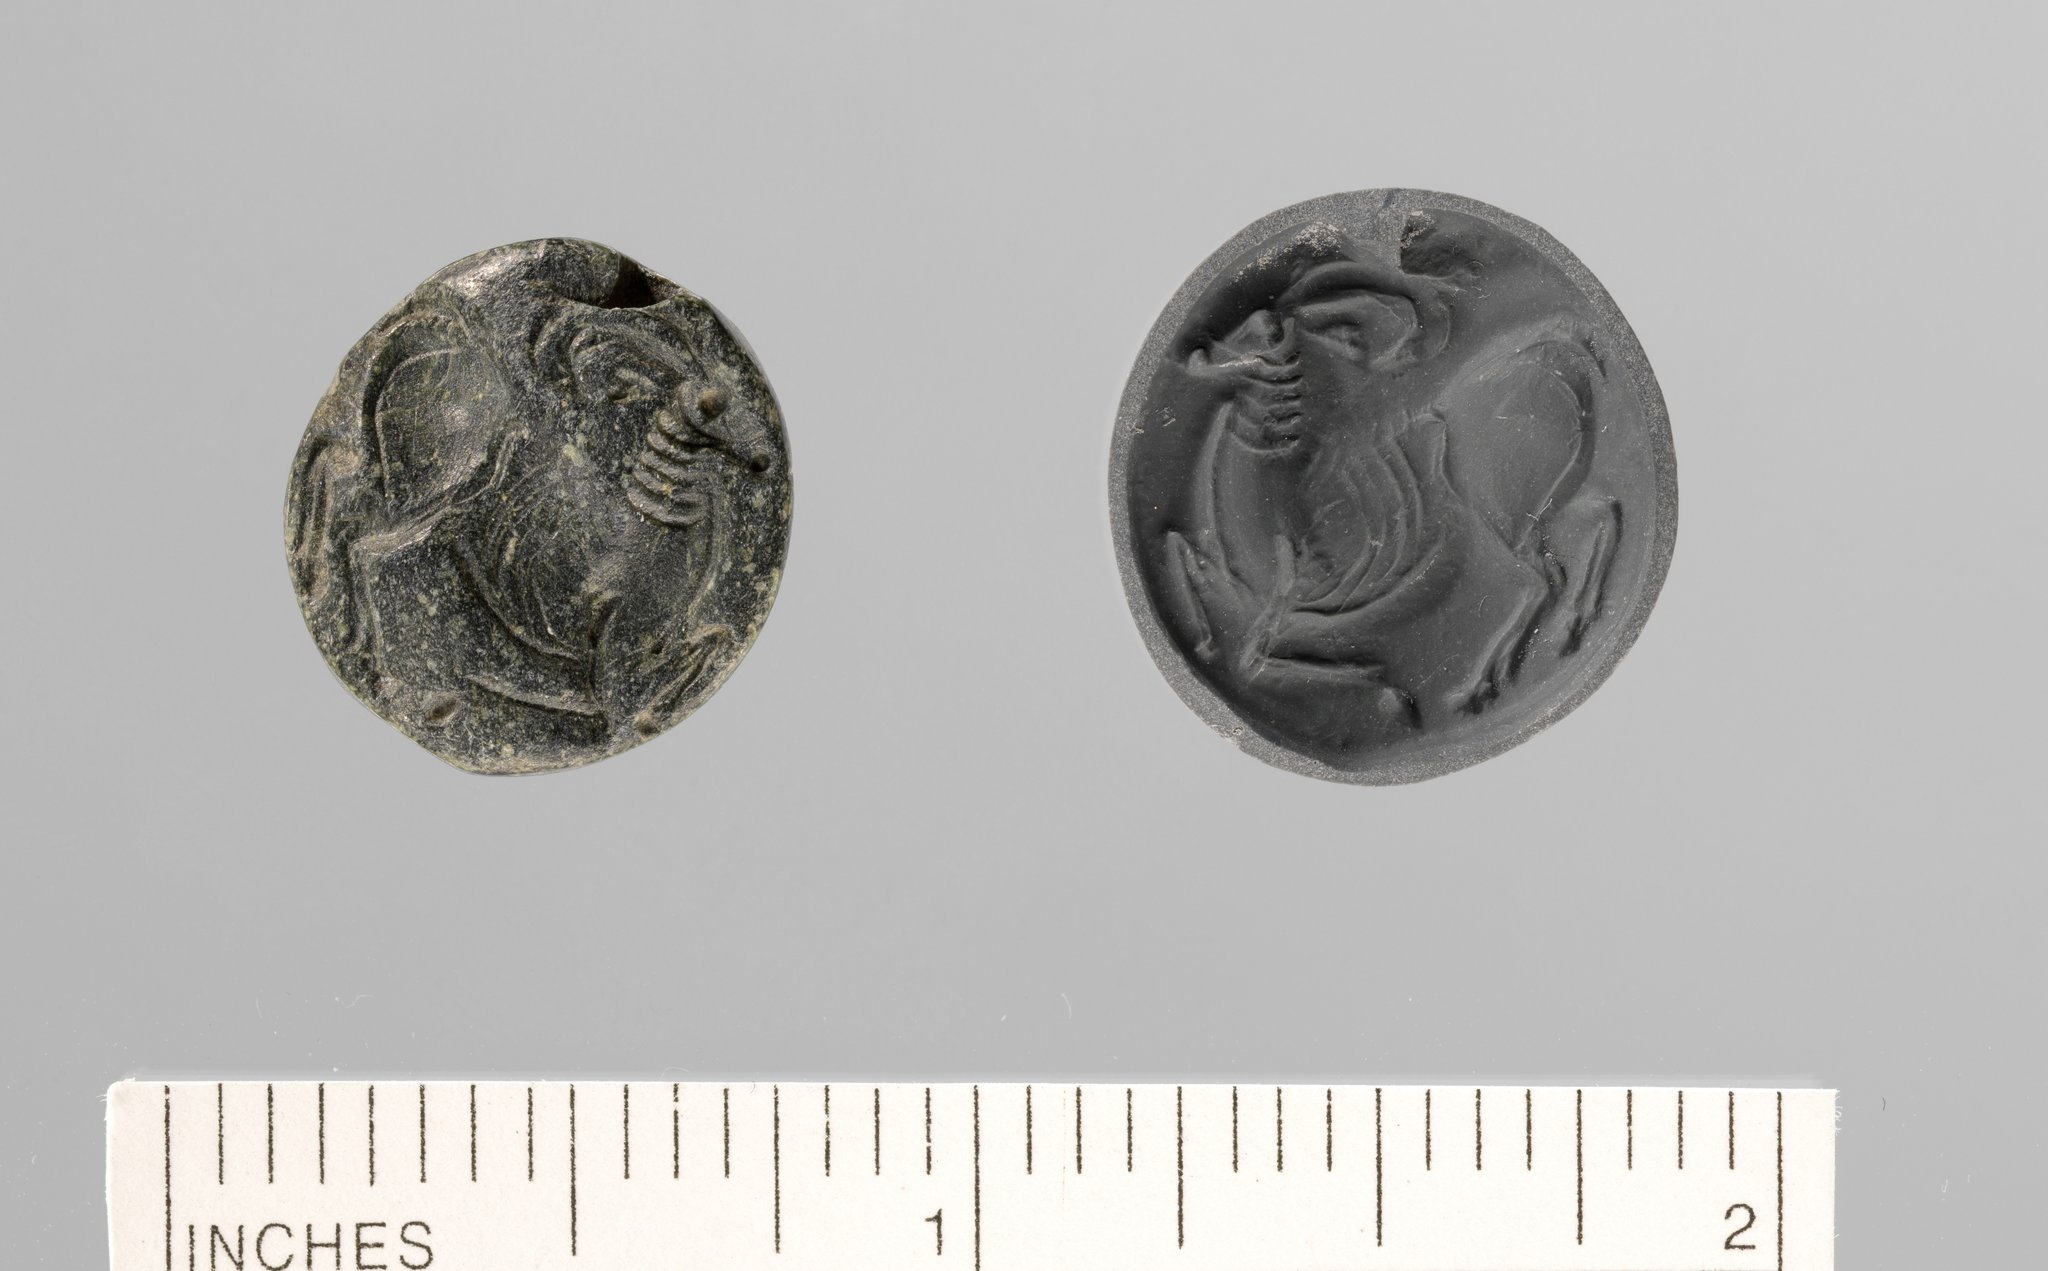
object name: seal, lentoid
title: Steatite Lentoid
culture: minoan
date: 1400-1375 BCE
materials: stone